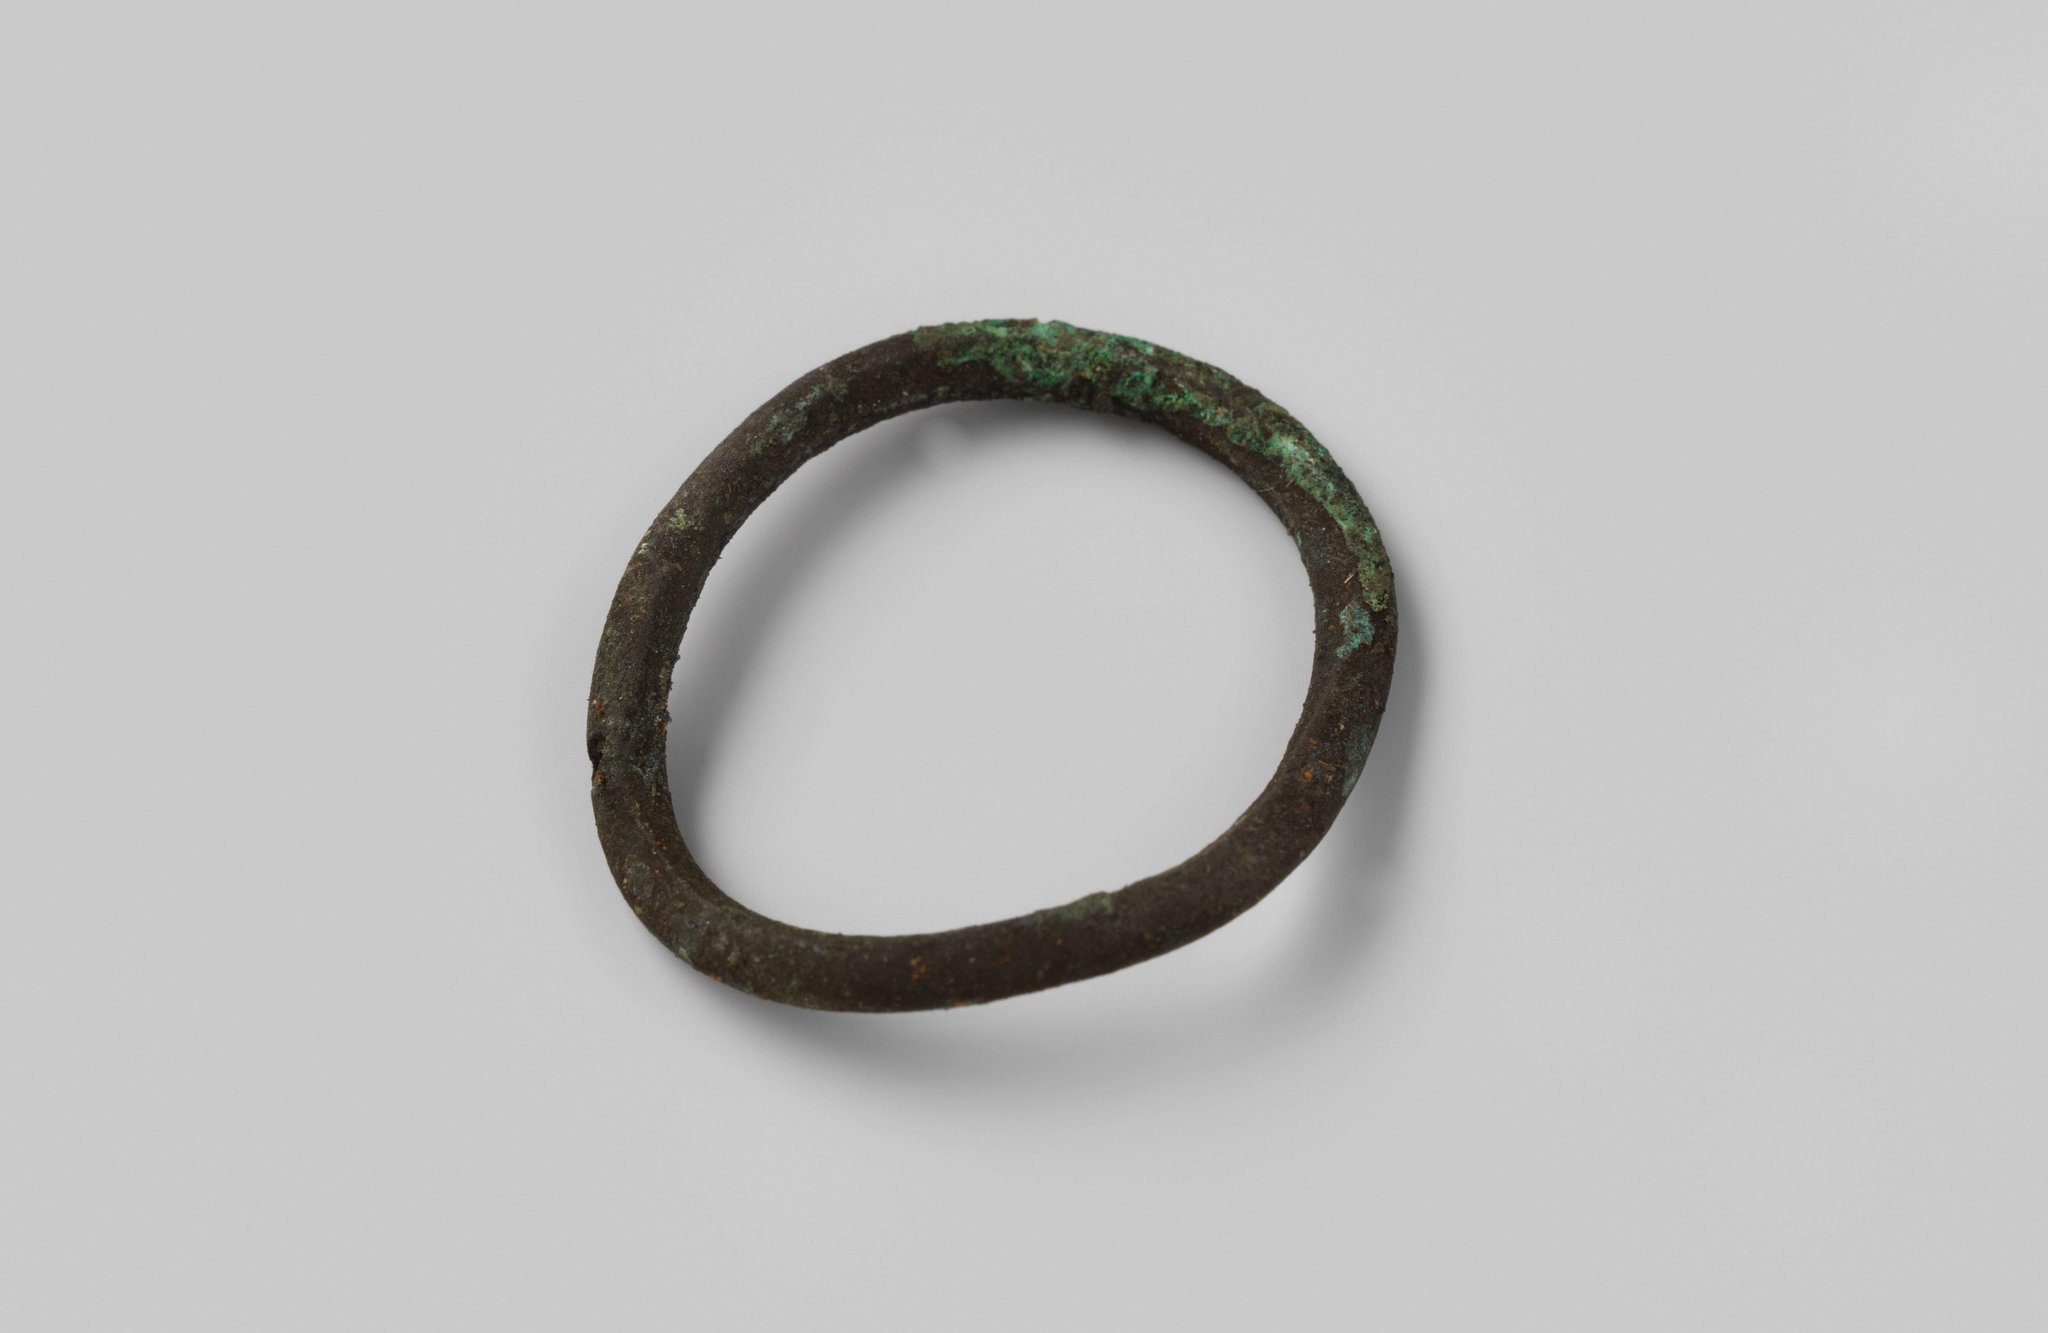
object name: ring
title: Ringvormig fragment uit het wrak van de Oost-Indiëvaarder Hollandia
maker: Anonymous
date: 1700-1743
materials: copper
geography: netherlands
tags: verenigde oostindische compagnie, hollandia (schip), annet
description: Varied parts or fragments, rings or ring-shaped fragments; squashed, id. 80H1.